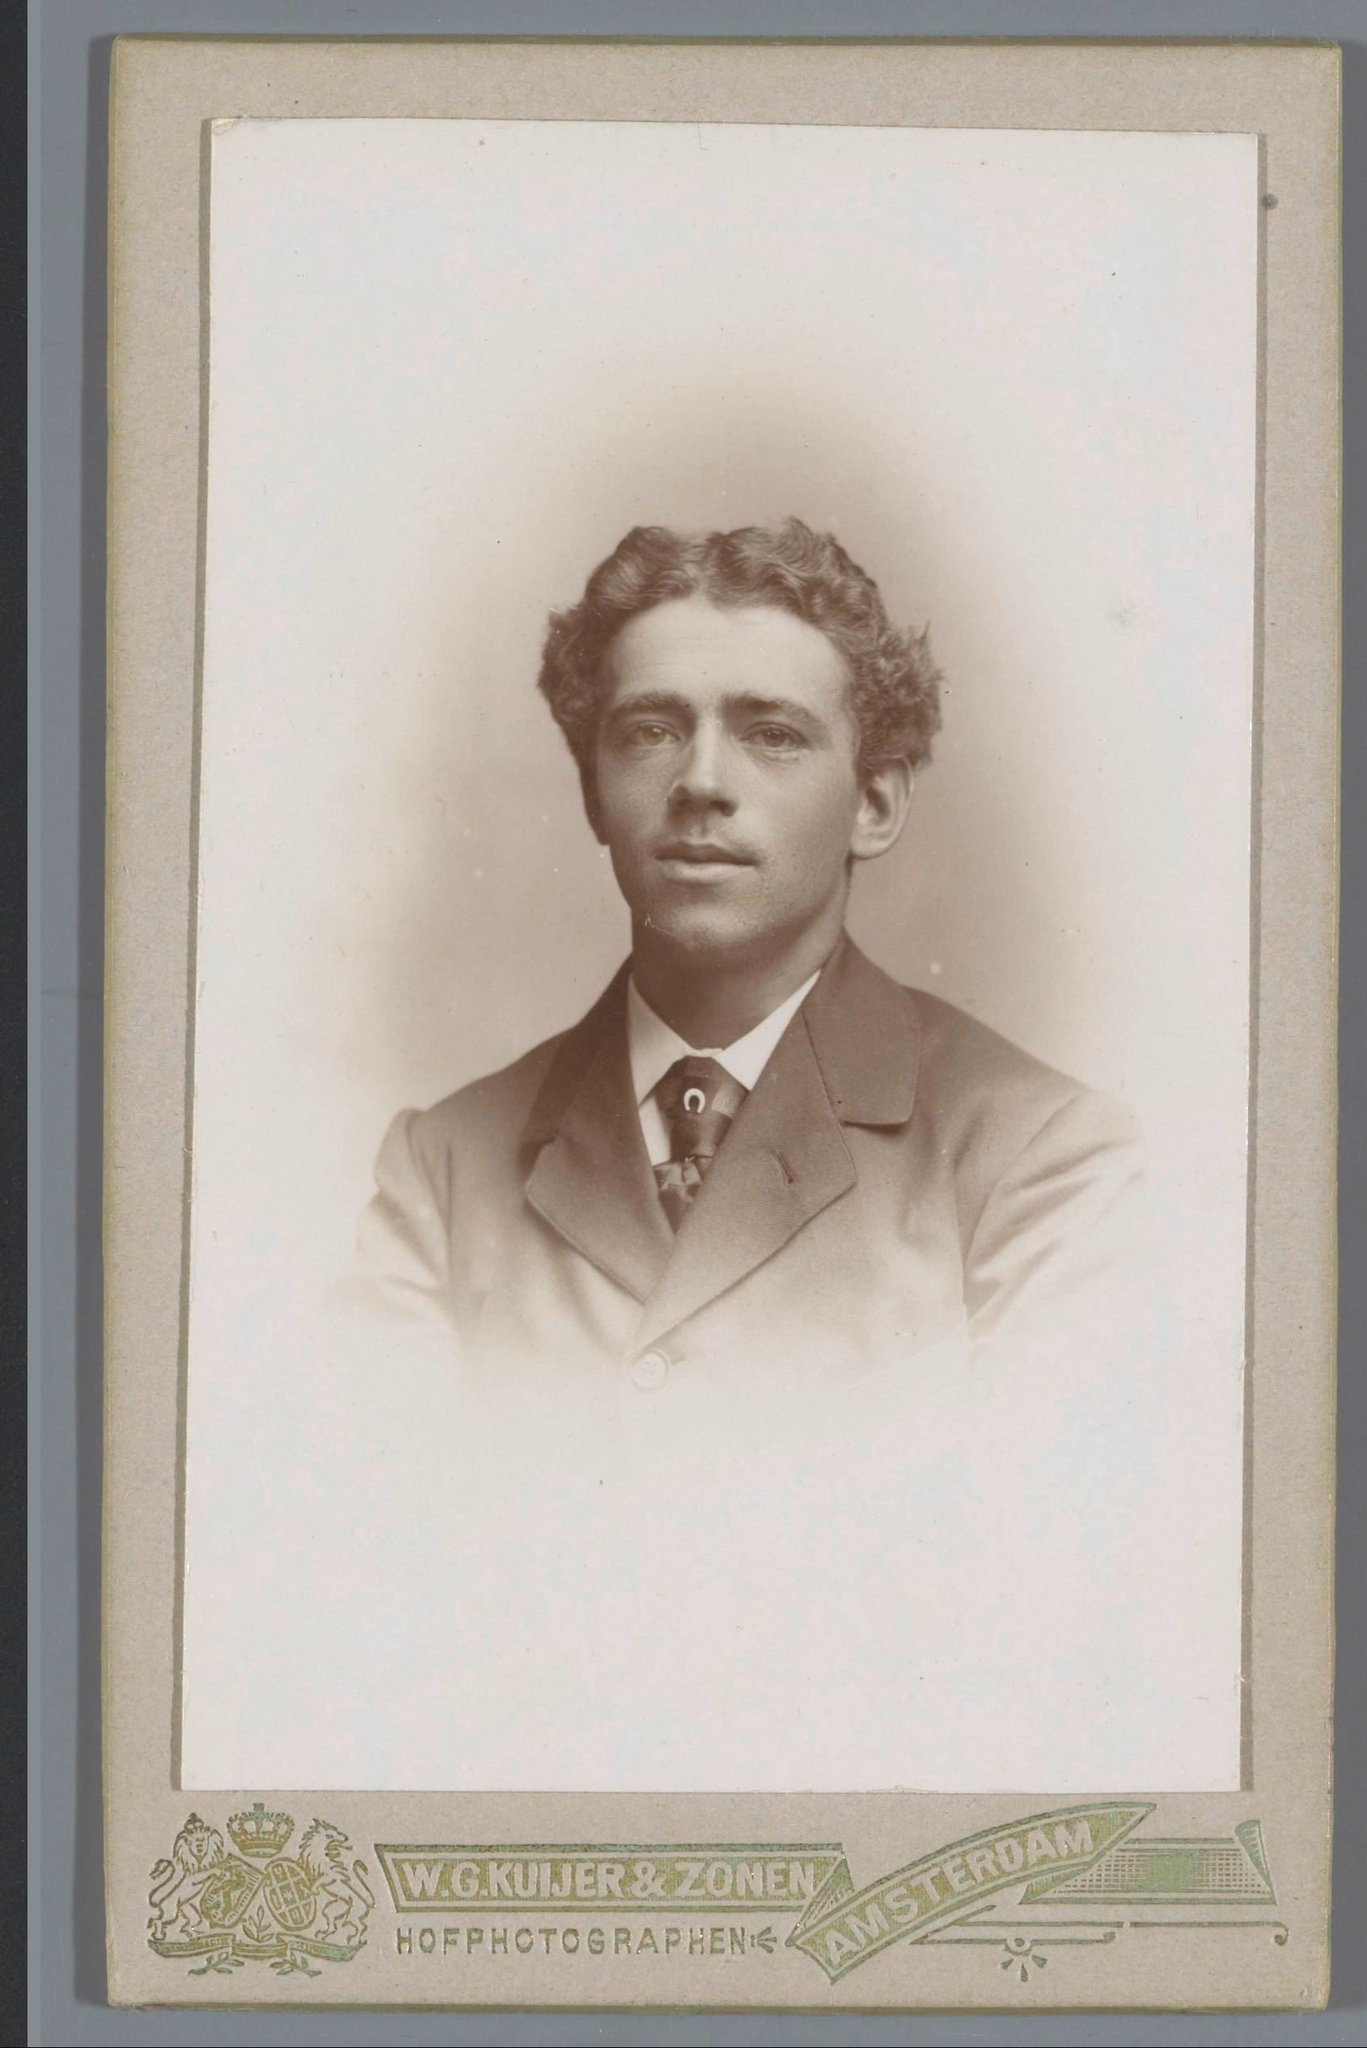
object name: photograph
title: Portret van Willem Visser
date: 1880-1906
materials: cardboard, photographic support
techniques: collodion silver print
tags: adult man, historical persons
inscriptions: inscription: ‘OPGERICHT 1864/ AMSTERDAM/ Westermarkt 19/ W. G. KUIJER & ZONEN/ HOFPHOTOGRAPHEN/ Speciale Inrichting/ voor/ VERGROOTINGEN/ in alle Formaten./ Prager & Lojda, Berlin/ 30599’, inscription: ‘Willem Visser’